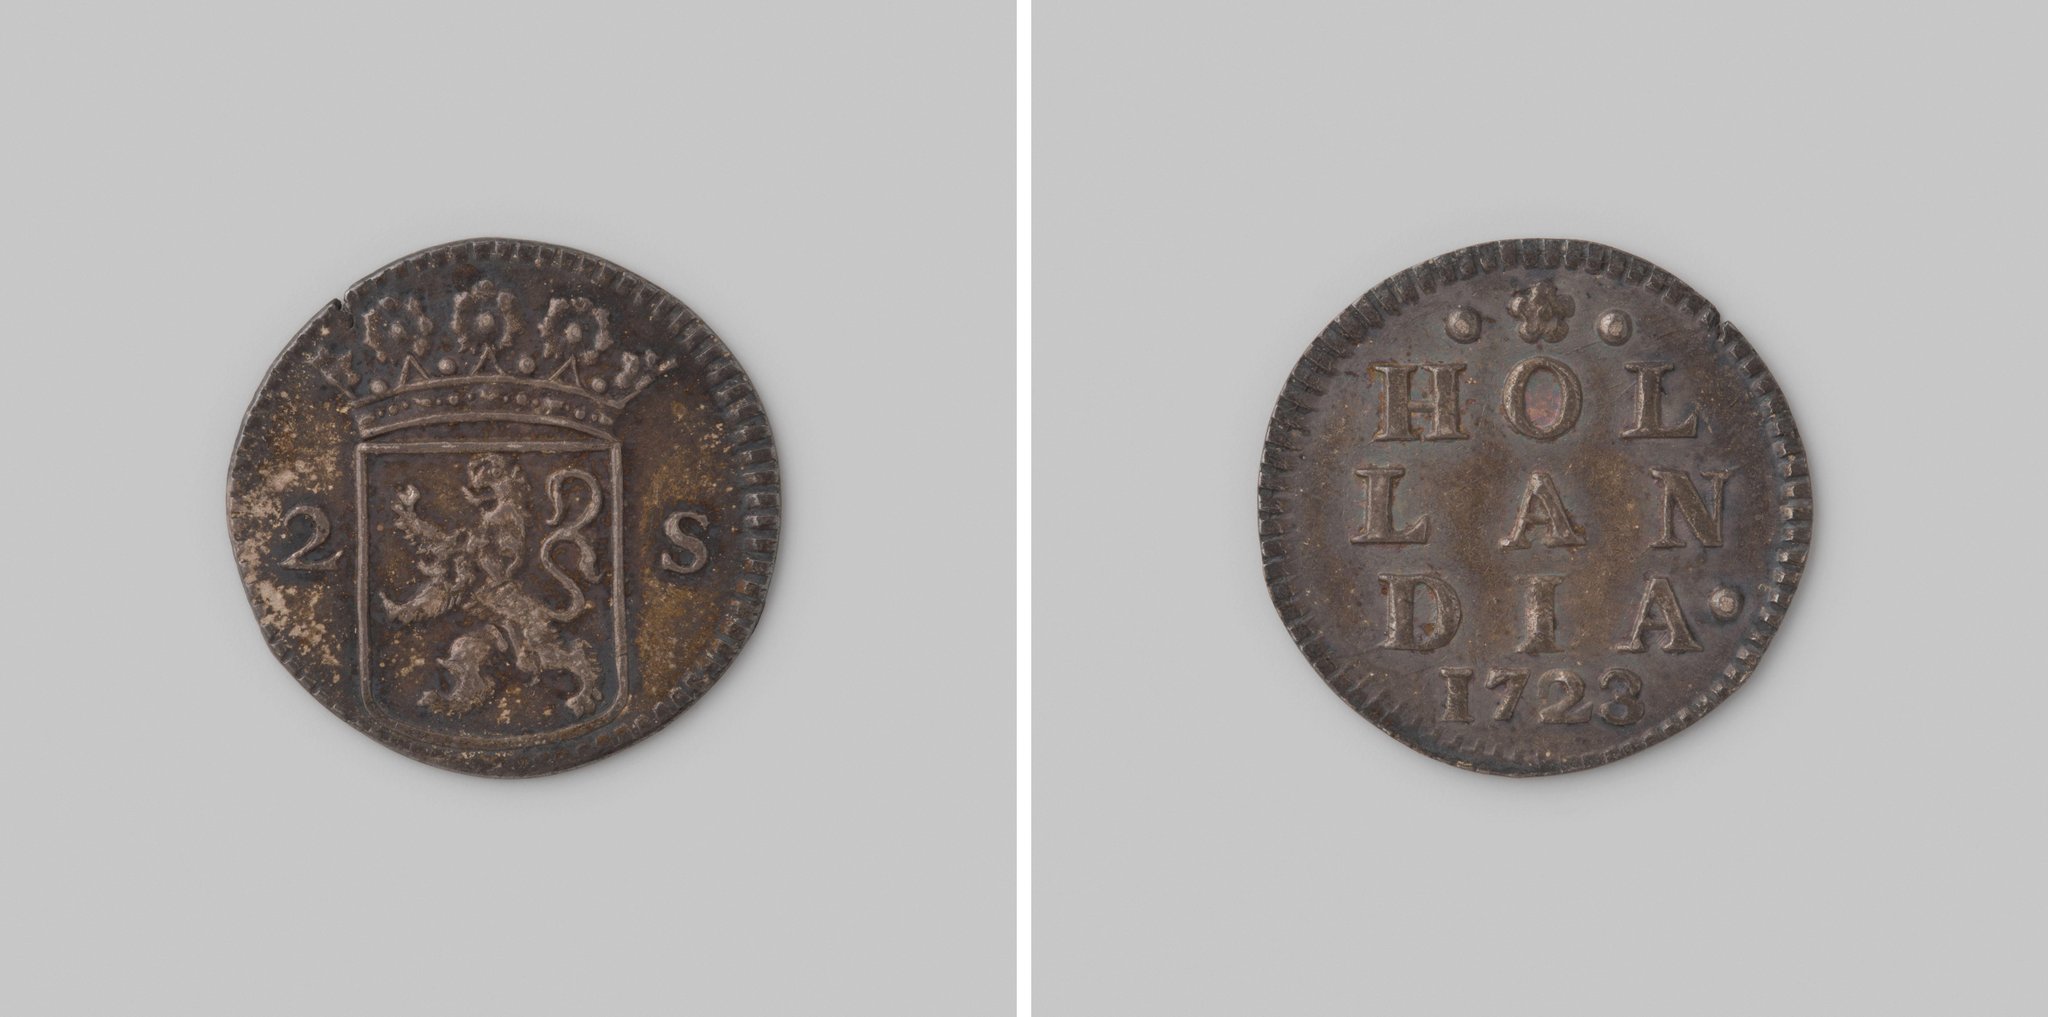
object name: coin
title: Holland, dubbele stuiver, 1723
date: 1723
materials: silver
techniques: striking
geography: dordrecht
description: Zilveren munt. Voorzijde: tussen waarde-aanduiding 2 S gekroond wapenschild van Holland. Keerzijde: opschrift: provincienaam in drie regels, daaronder jaartal.